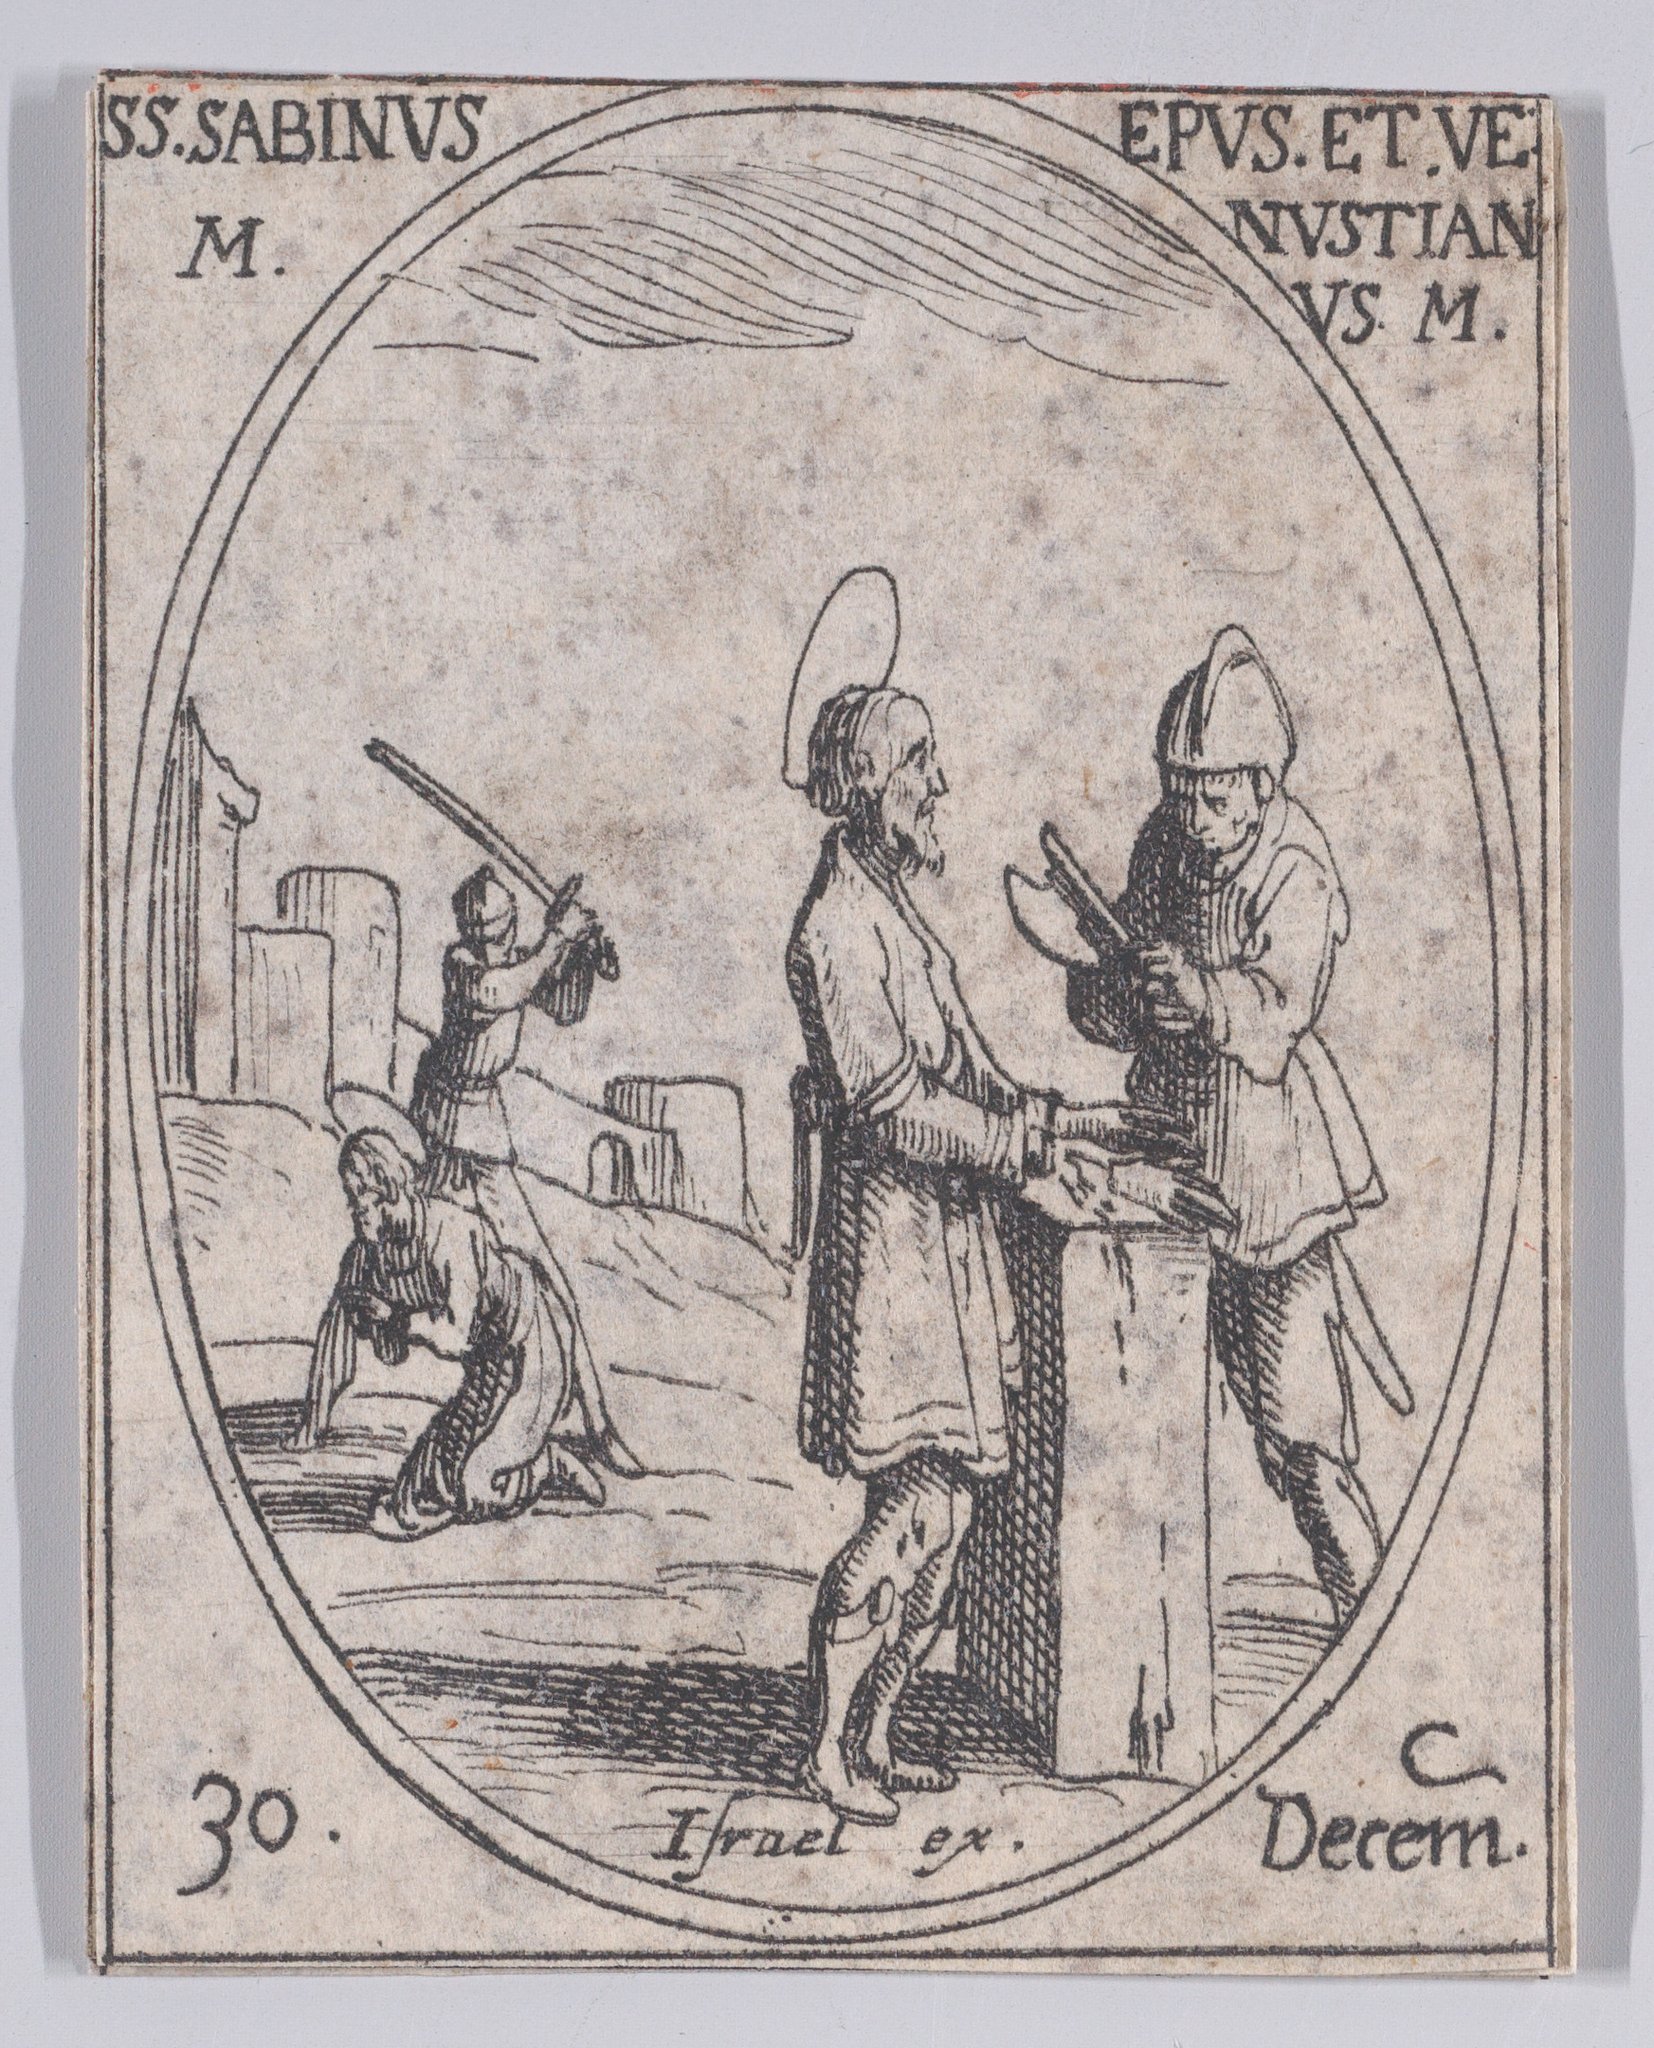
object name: print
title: S. Sabin et S. Vénustien (St. Sabinus and St. Venustian), December 30th, from "Les Images De Tous Les Saincts et Saintes de L'Année" (Images of All of the Saints and Religious Events of the Year)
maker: jacques callot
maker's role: artist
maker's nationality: french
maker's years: 1592-1635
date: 1636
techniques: etching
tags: men,saints